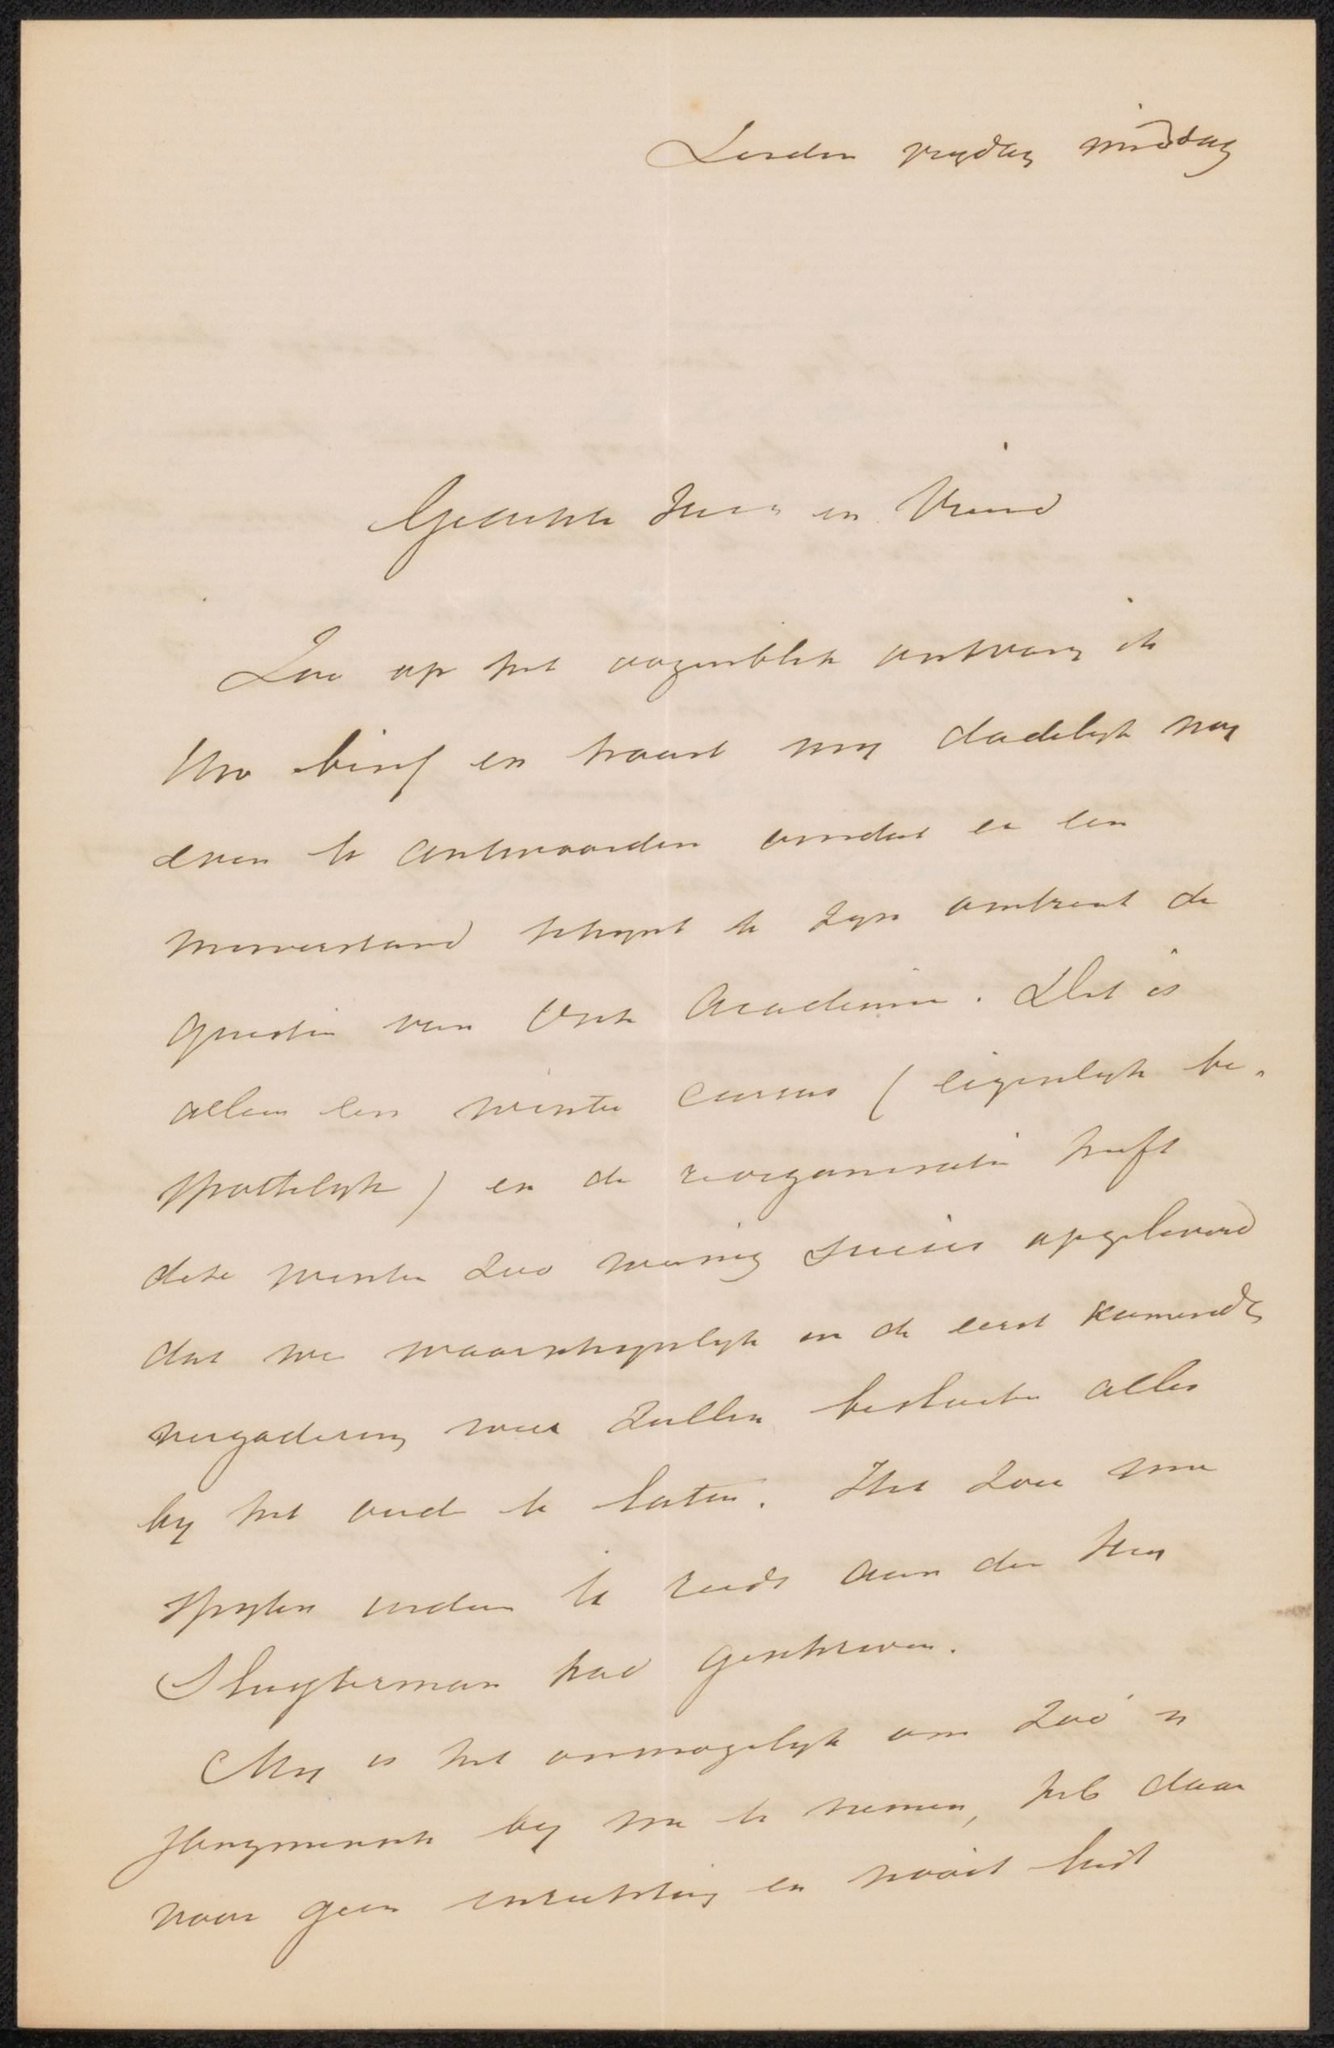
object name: letter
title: Brief aan August Allebé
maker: alexander hugo bakker korff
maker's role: draughtsman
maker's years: 1824-1882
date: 1848-1882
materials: ink, paper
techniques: pen, writing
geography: leiden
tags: draughtsman, amsterdam, august allebé, drawing, education, tuition of the artist (in general)